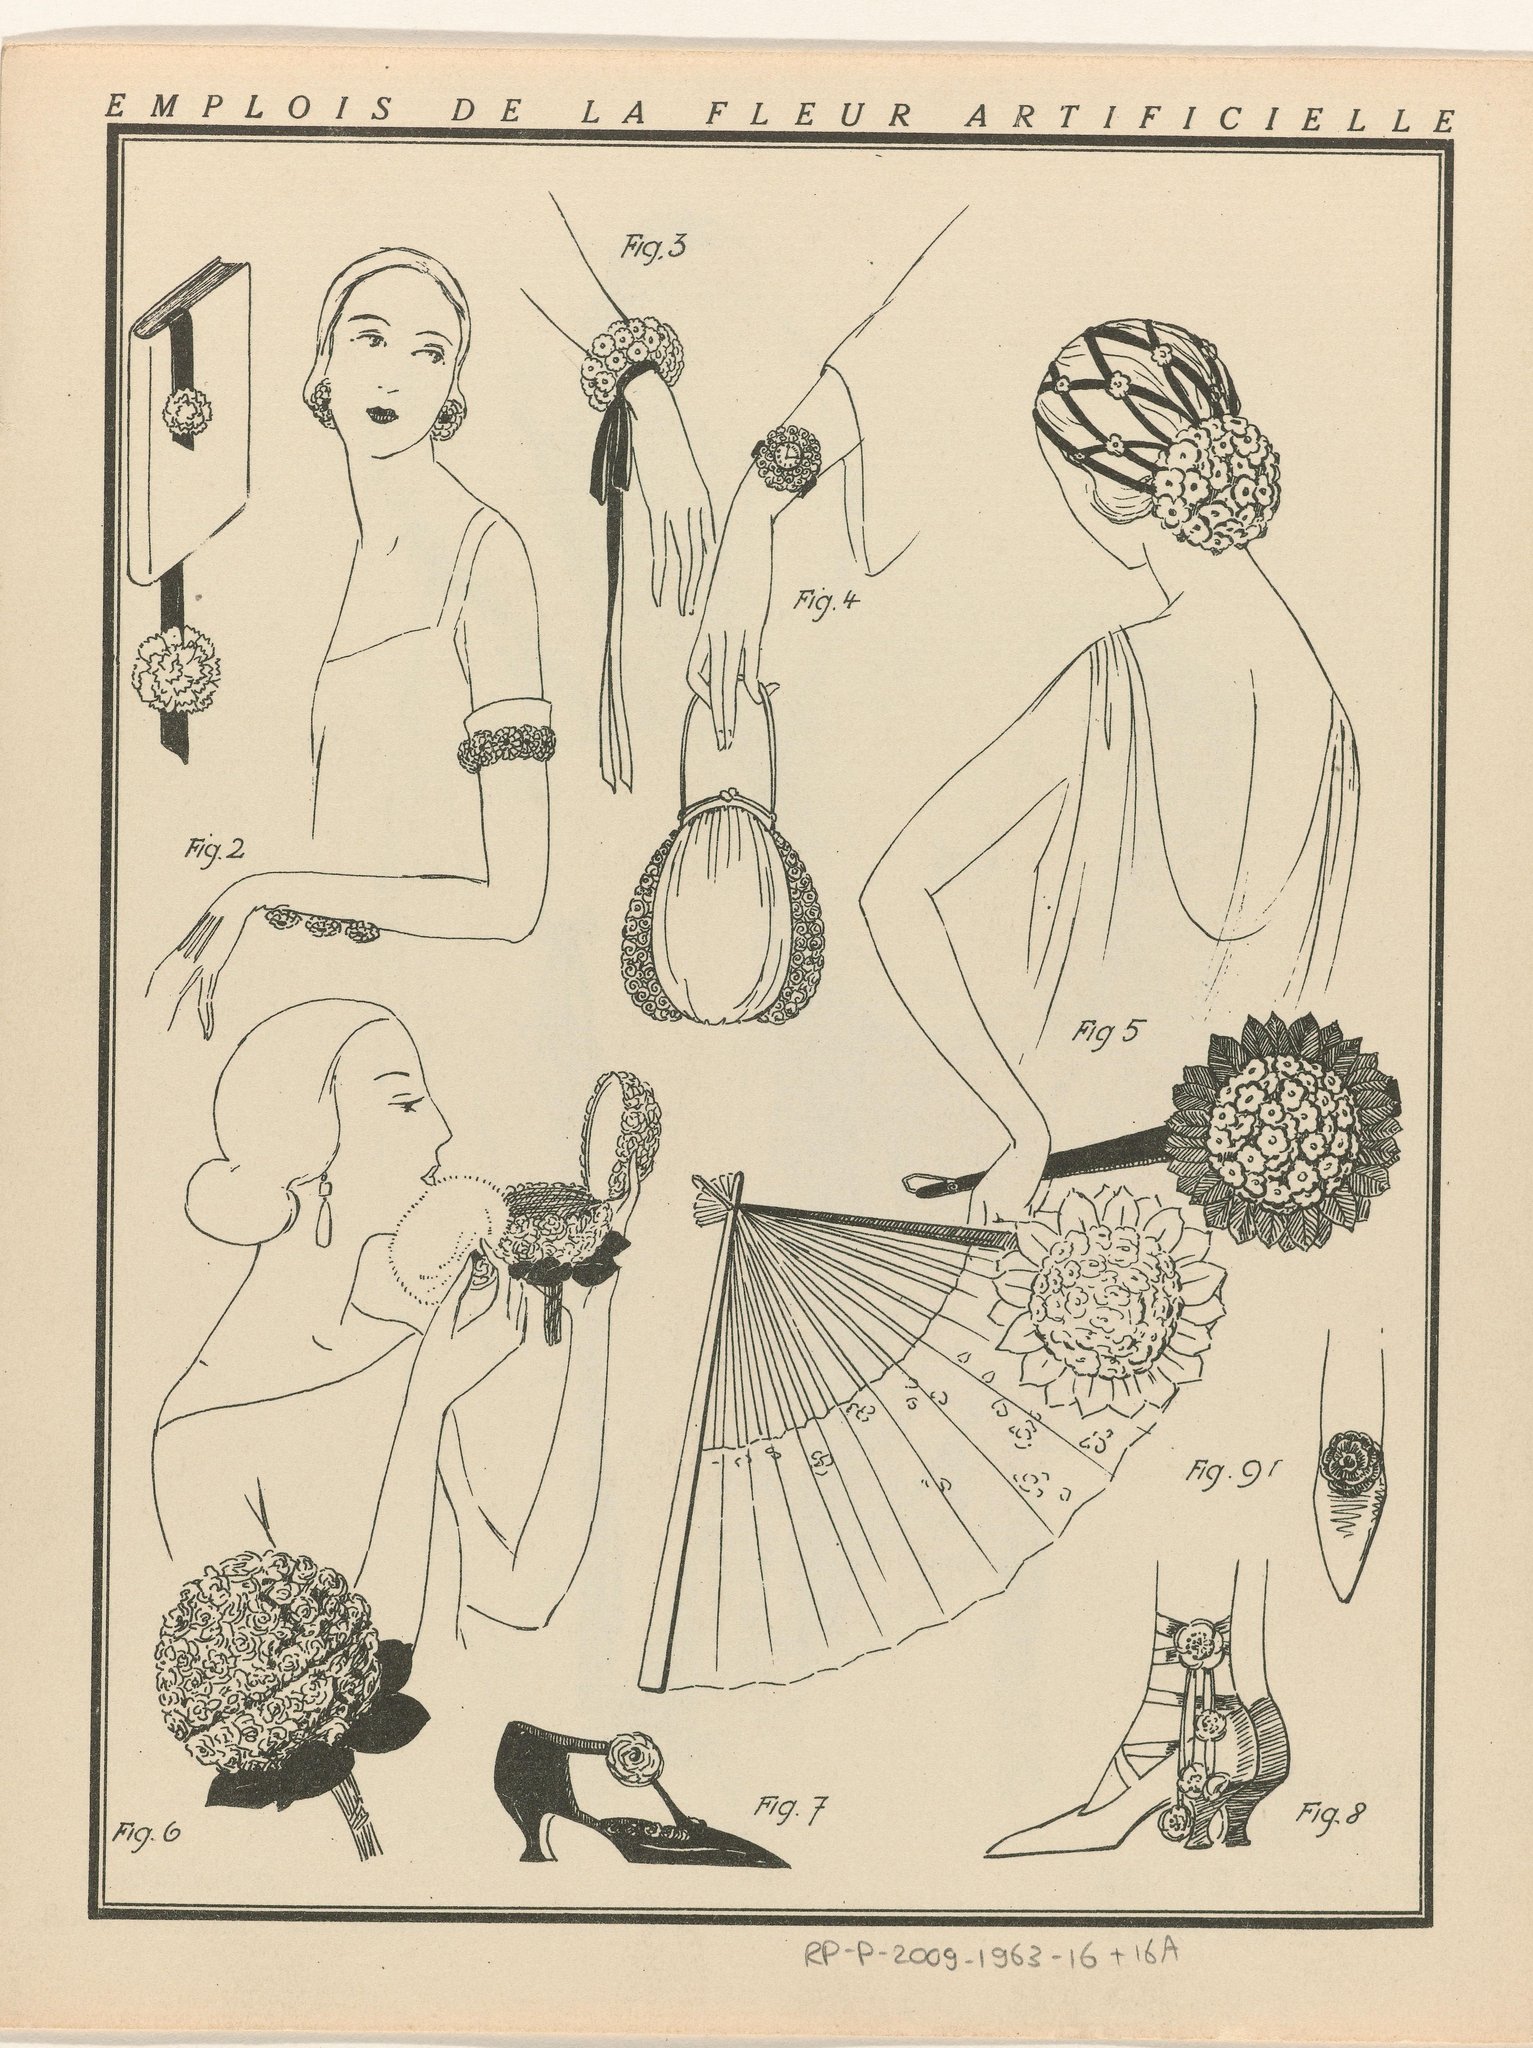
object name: fashion print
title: Accessories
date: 1922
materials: paper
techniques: letterpress printing, lithograph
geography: london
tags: bag (handbag) (+ women's clothes), artificial plants and flowers, fashion plates, shoes, sandals (+ women's clothes), gloves, mittens, etc. (+ women's clothes), fan (+ women's clothes), bracelet, wristlet (+ women's clothes)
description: Fans, parasols, opera gloves, fashionable hats, small toques garnished with feathers, wristwatches, compact bracelets, and luxuriously crafted lighters: there was a dazzling variety of accessories in the 1920s. Small bags could be suspended from a belt, or a glove. Walking sticks and the shafts of umbrellas and parasols were often embellished with carving clearly inspired by African and Indian art. And Russian influence was evident when it came to combs made of mother-of-pearl and ivory.